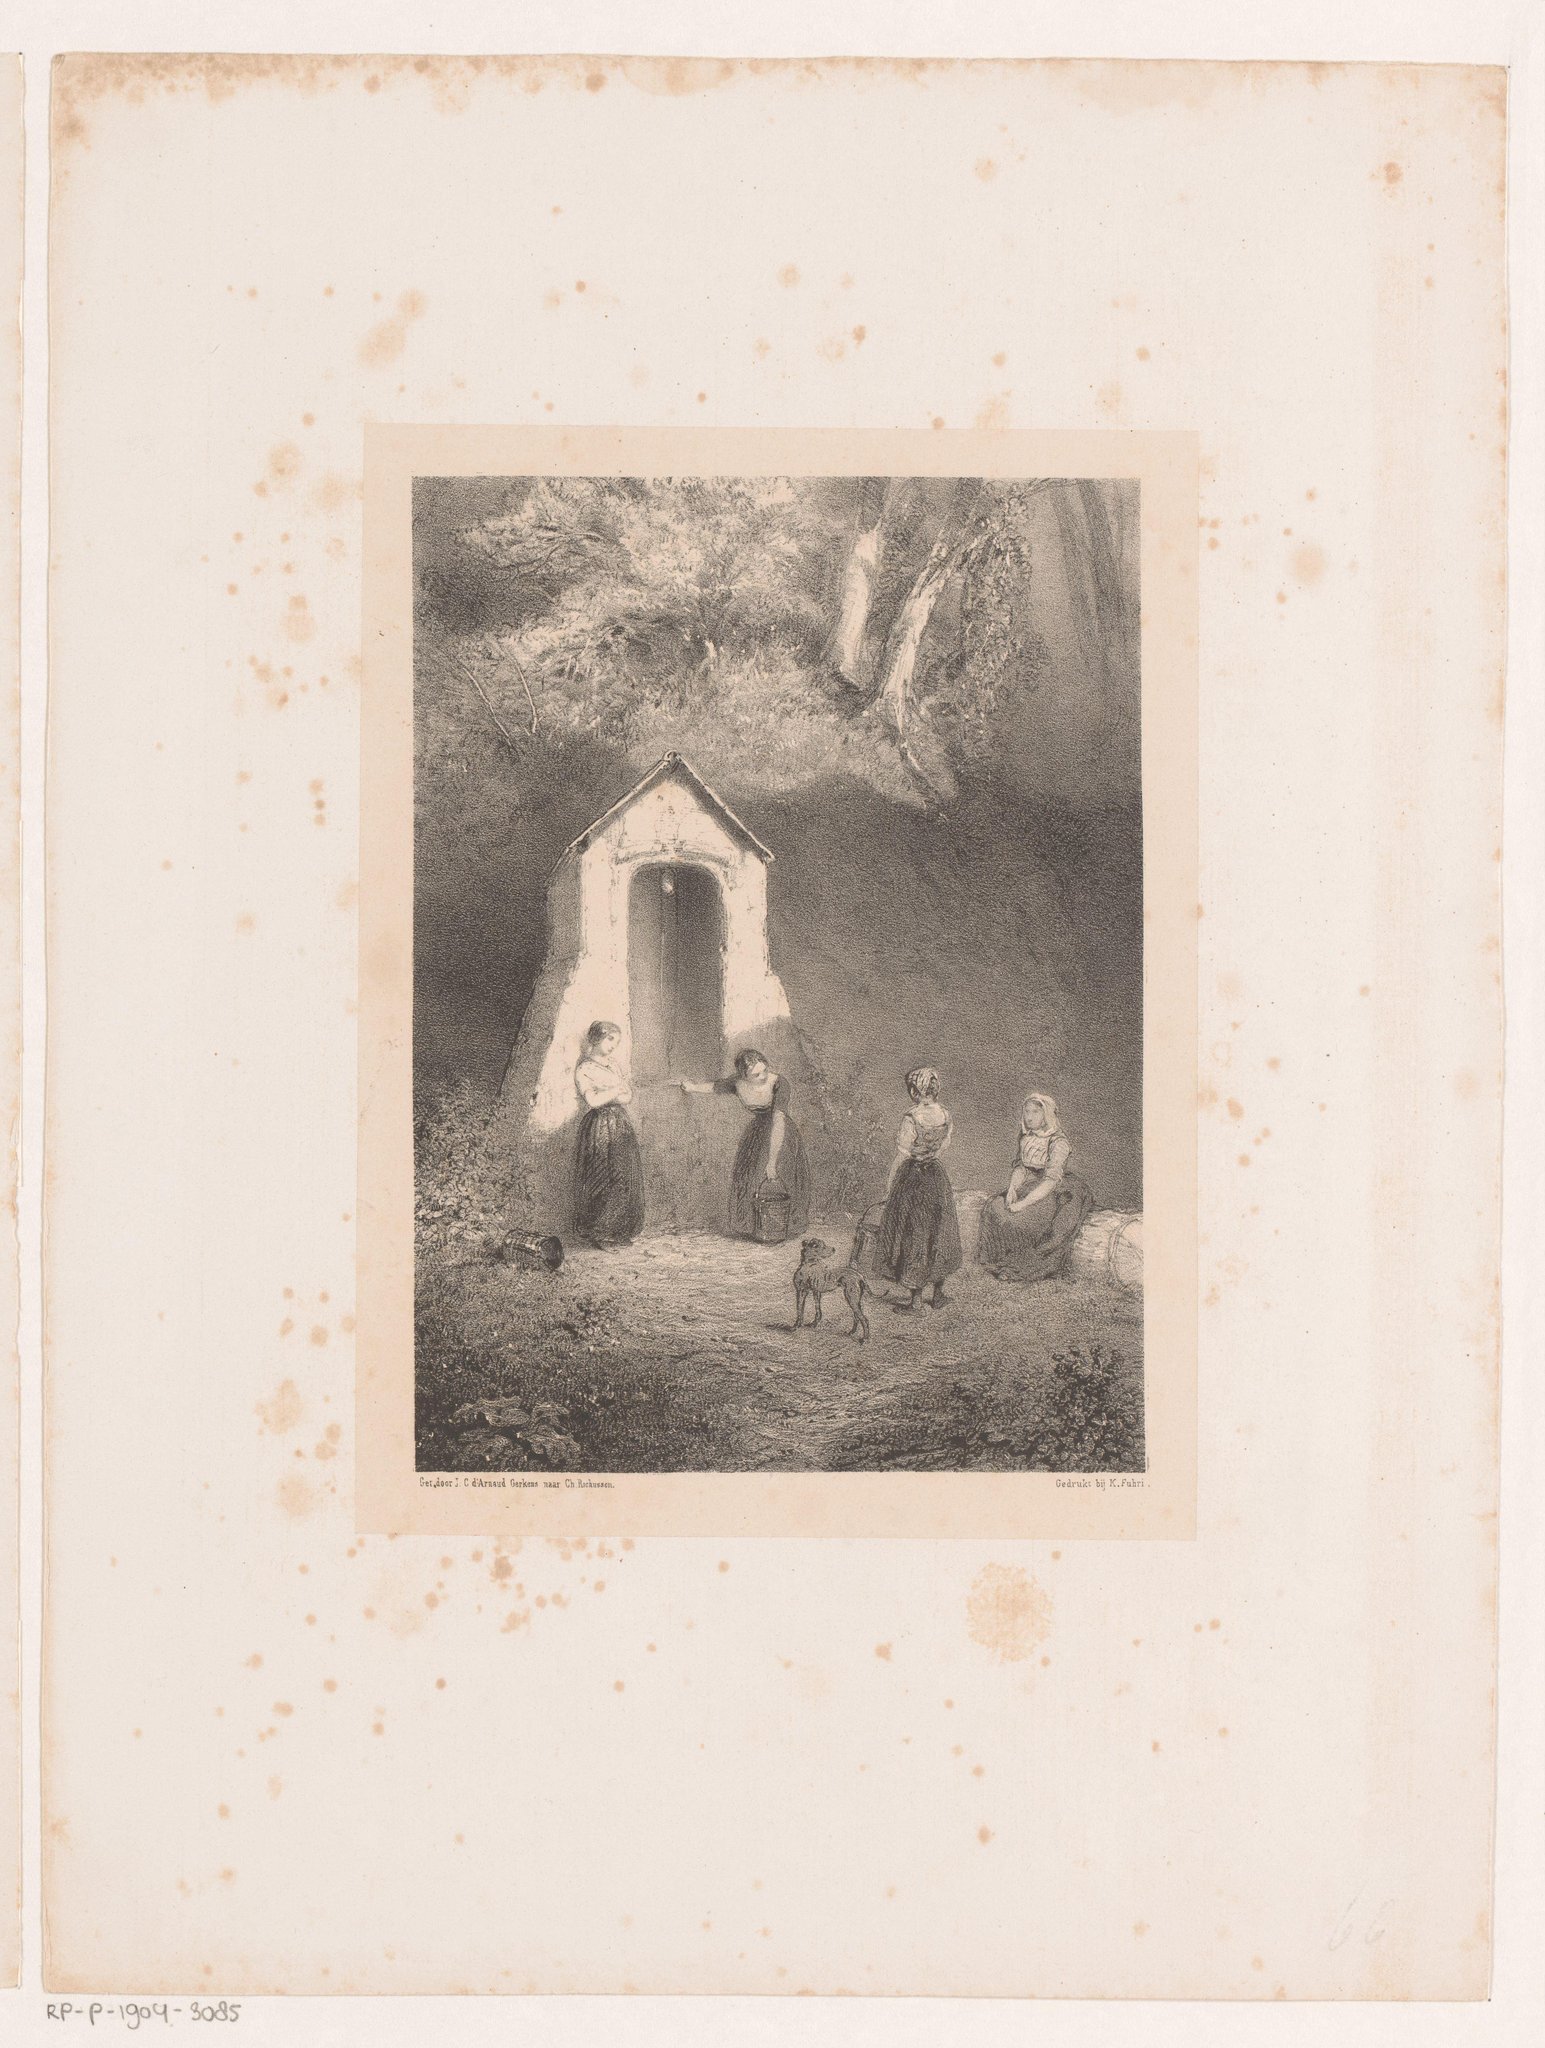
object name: print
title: Vier meisjes bij een put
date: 1837-1853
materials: paper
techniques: lithograph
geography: the hague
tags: well, adolescent, young woman, maiden, dog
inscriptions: collector's mark: Lugt 2228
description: De put staat in het bos. Bij de meisjes staat een hond.